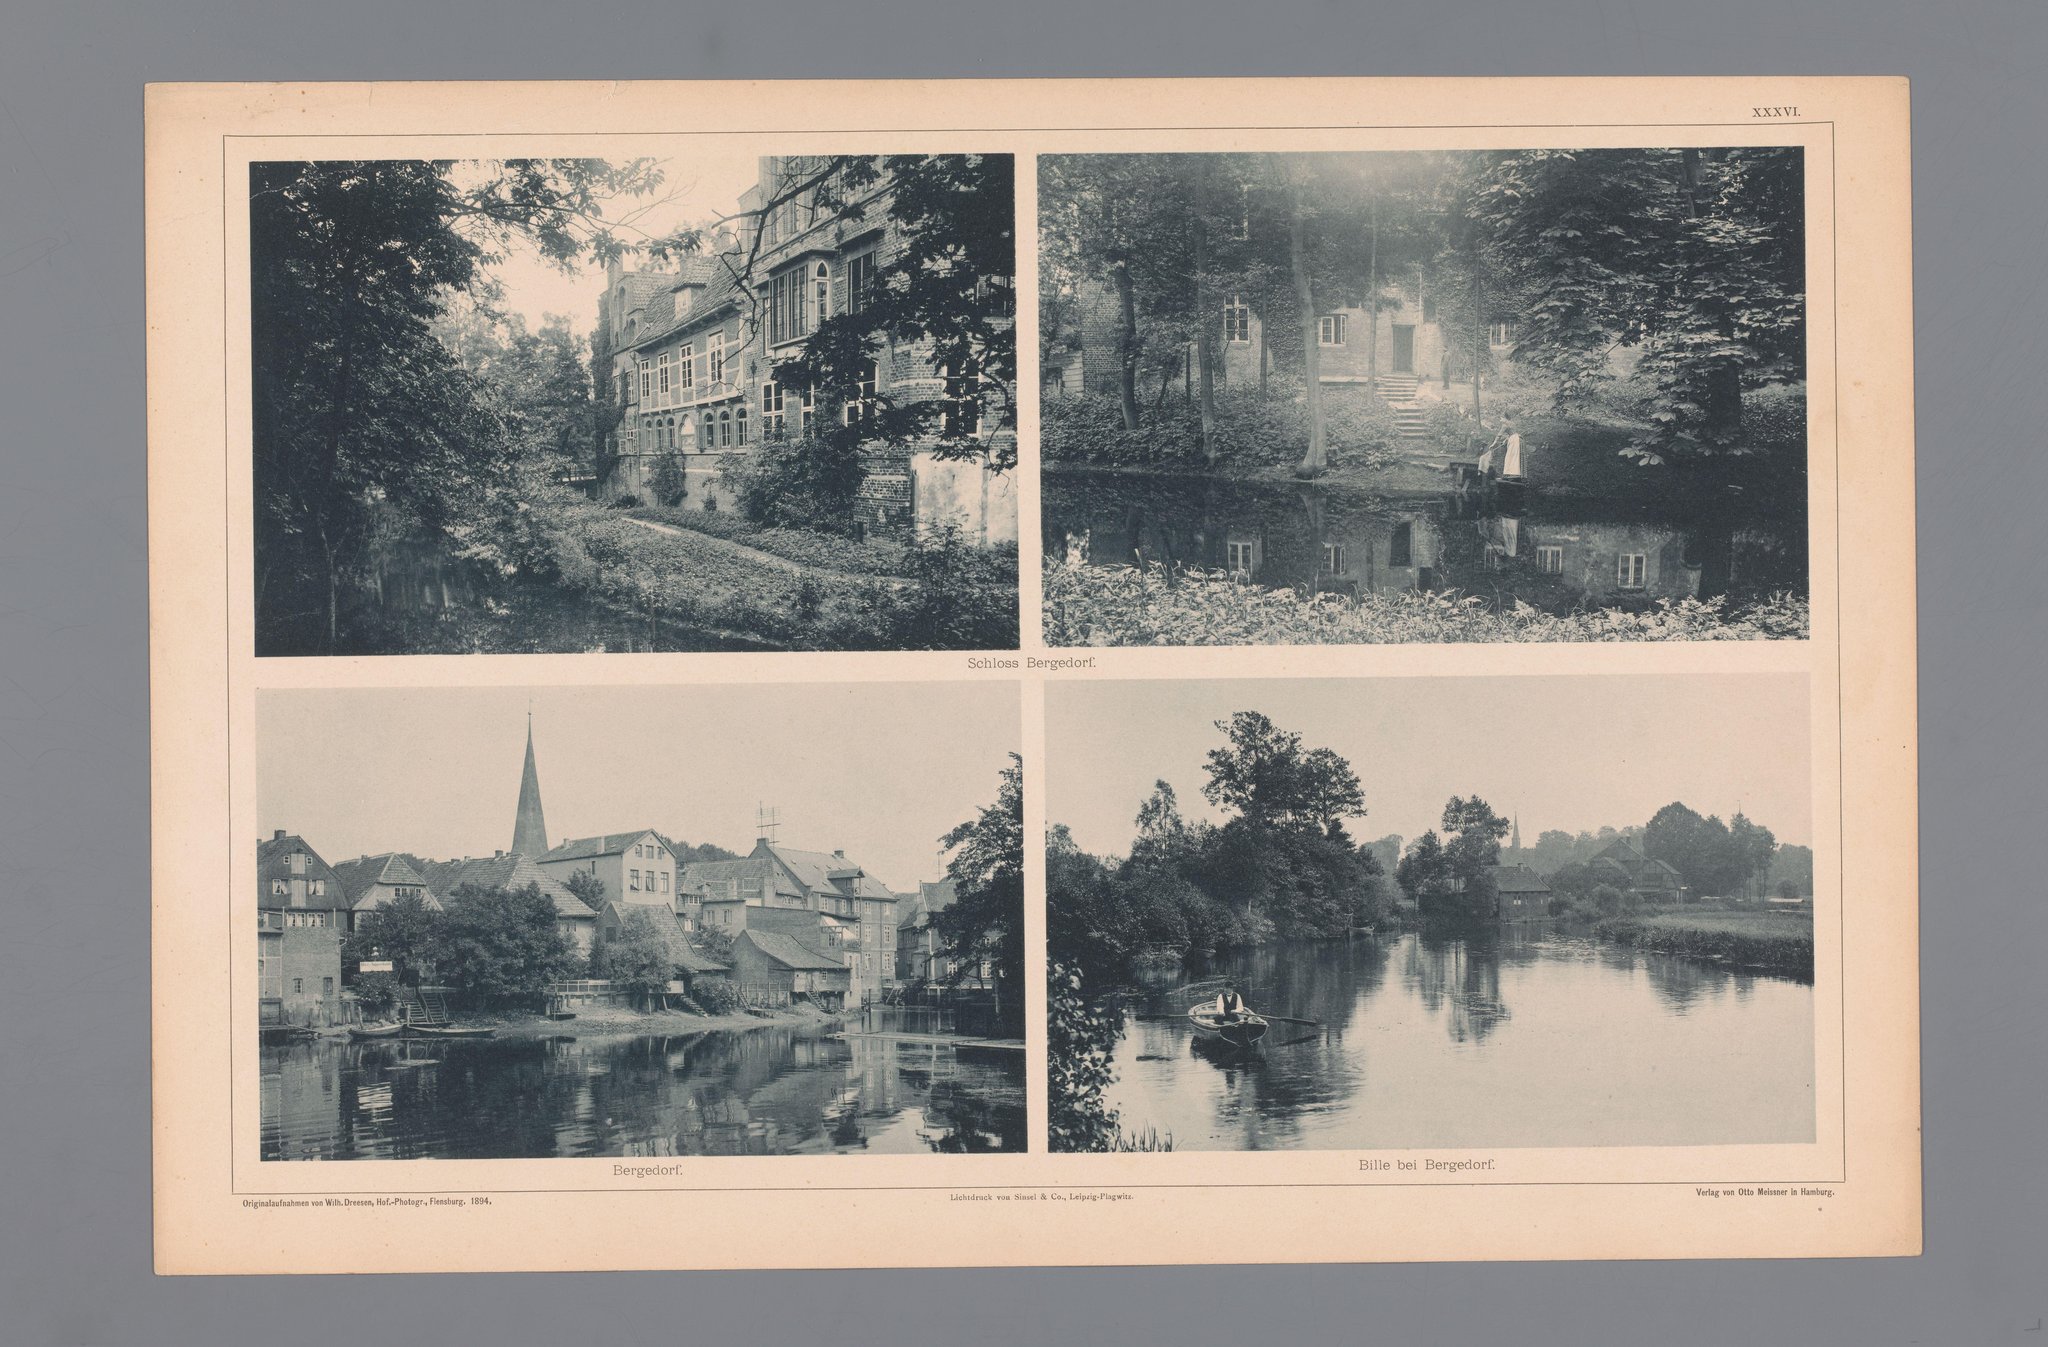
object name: photomechanical print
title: Bille bei Bergedorf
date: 1894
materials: paper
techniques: photograph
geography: hamburg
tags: draughtsman, matthias claudius, castle, canals, waters (in city)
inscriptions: inscription: ‘Originalaufnahmen von Wilh. Dreesen, Hof.-Photogr., Flensburg. 1894.’, number: ‘XXXVI.’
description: Deze prenten maken deel uit van een omslag met 126 prenten op 37 bladen en een tekstblad.